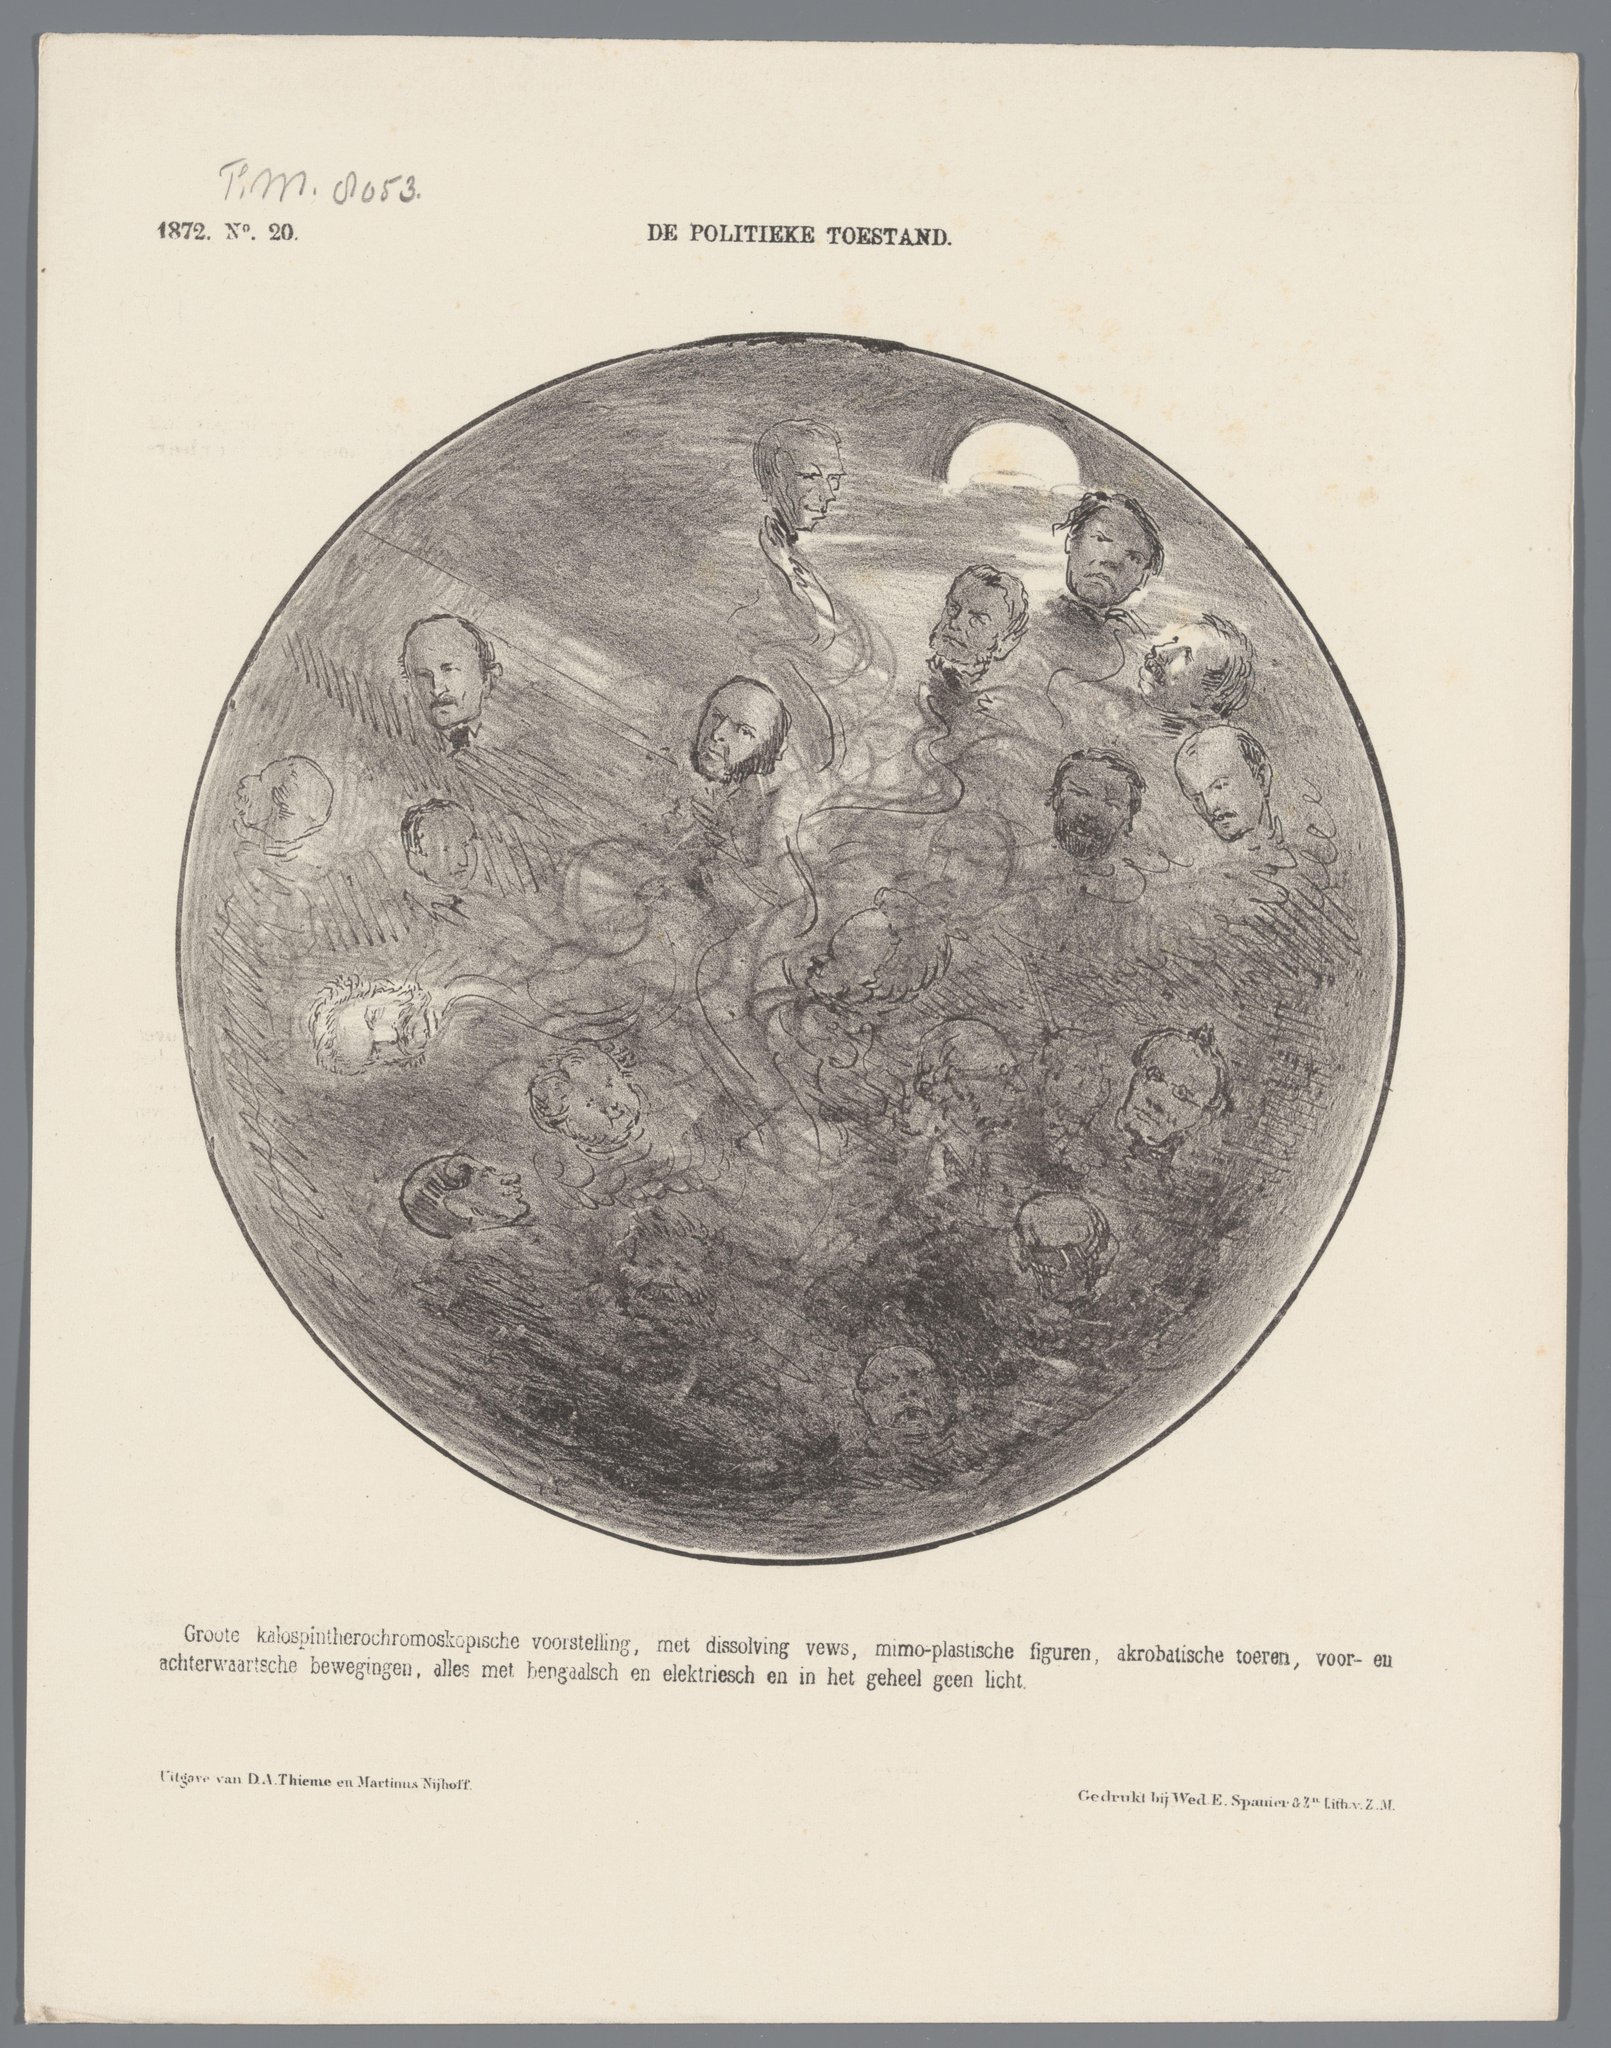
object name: print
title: Spotprent op de onduidelijke politieke toestand, 1872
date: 1872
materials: paper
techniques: lithograph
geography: netherlands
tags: johan rudolf thorbecke, minister ~ government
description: Spotprent op de onduidelijke politieke toestand in het land. Ronde telescopische voorstelling met hoofden van ministers zwevend door de ruimte, bovenaan Thorbecke en de maan. Plaat verschenen bij het weekblad De Nederlandsche Spectator, nr. 20, 1872.